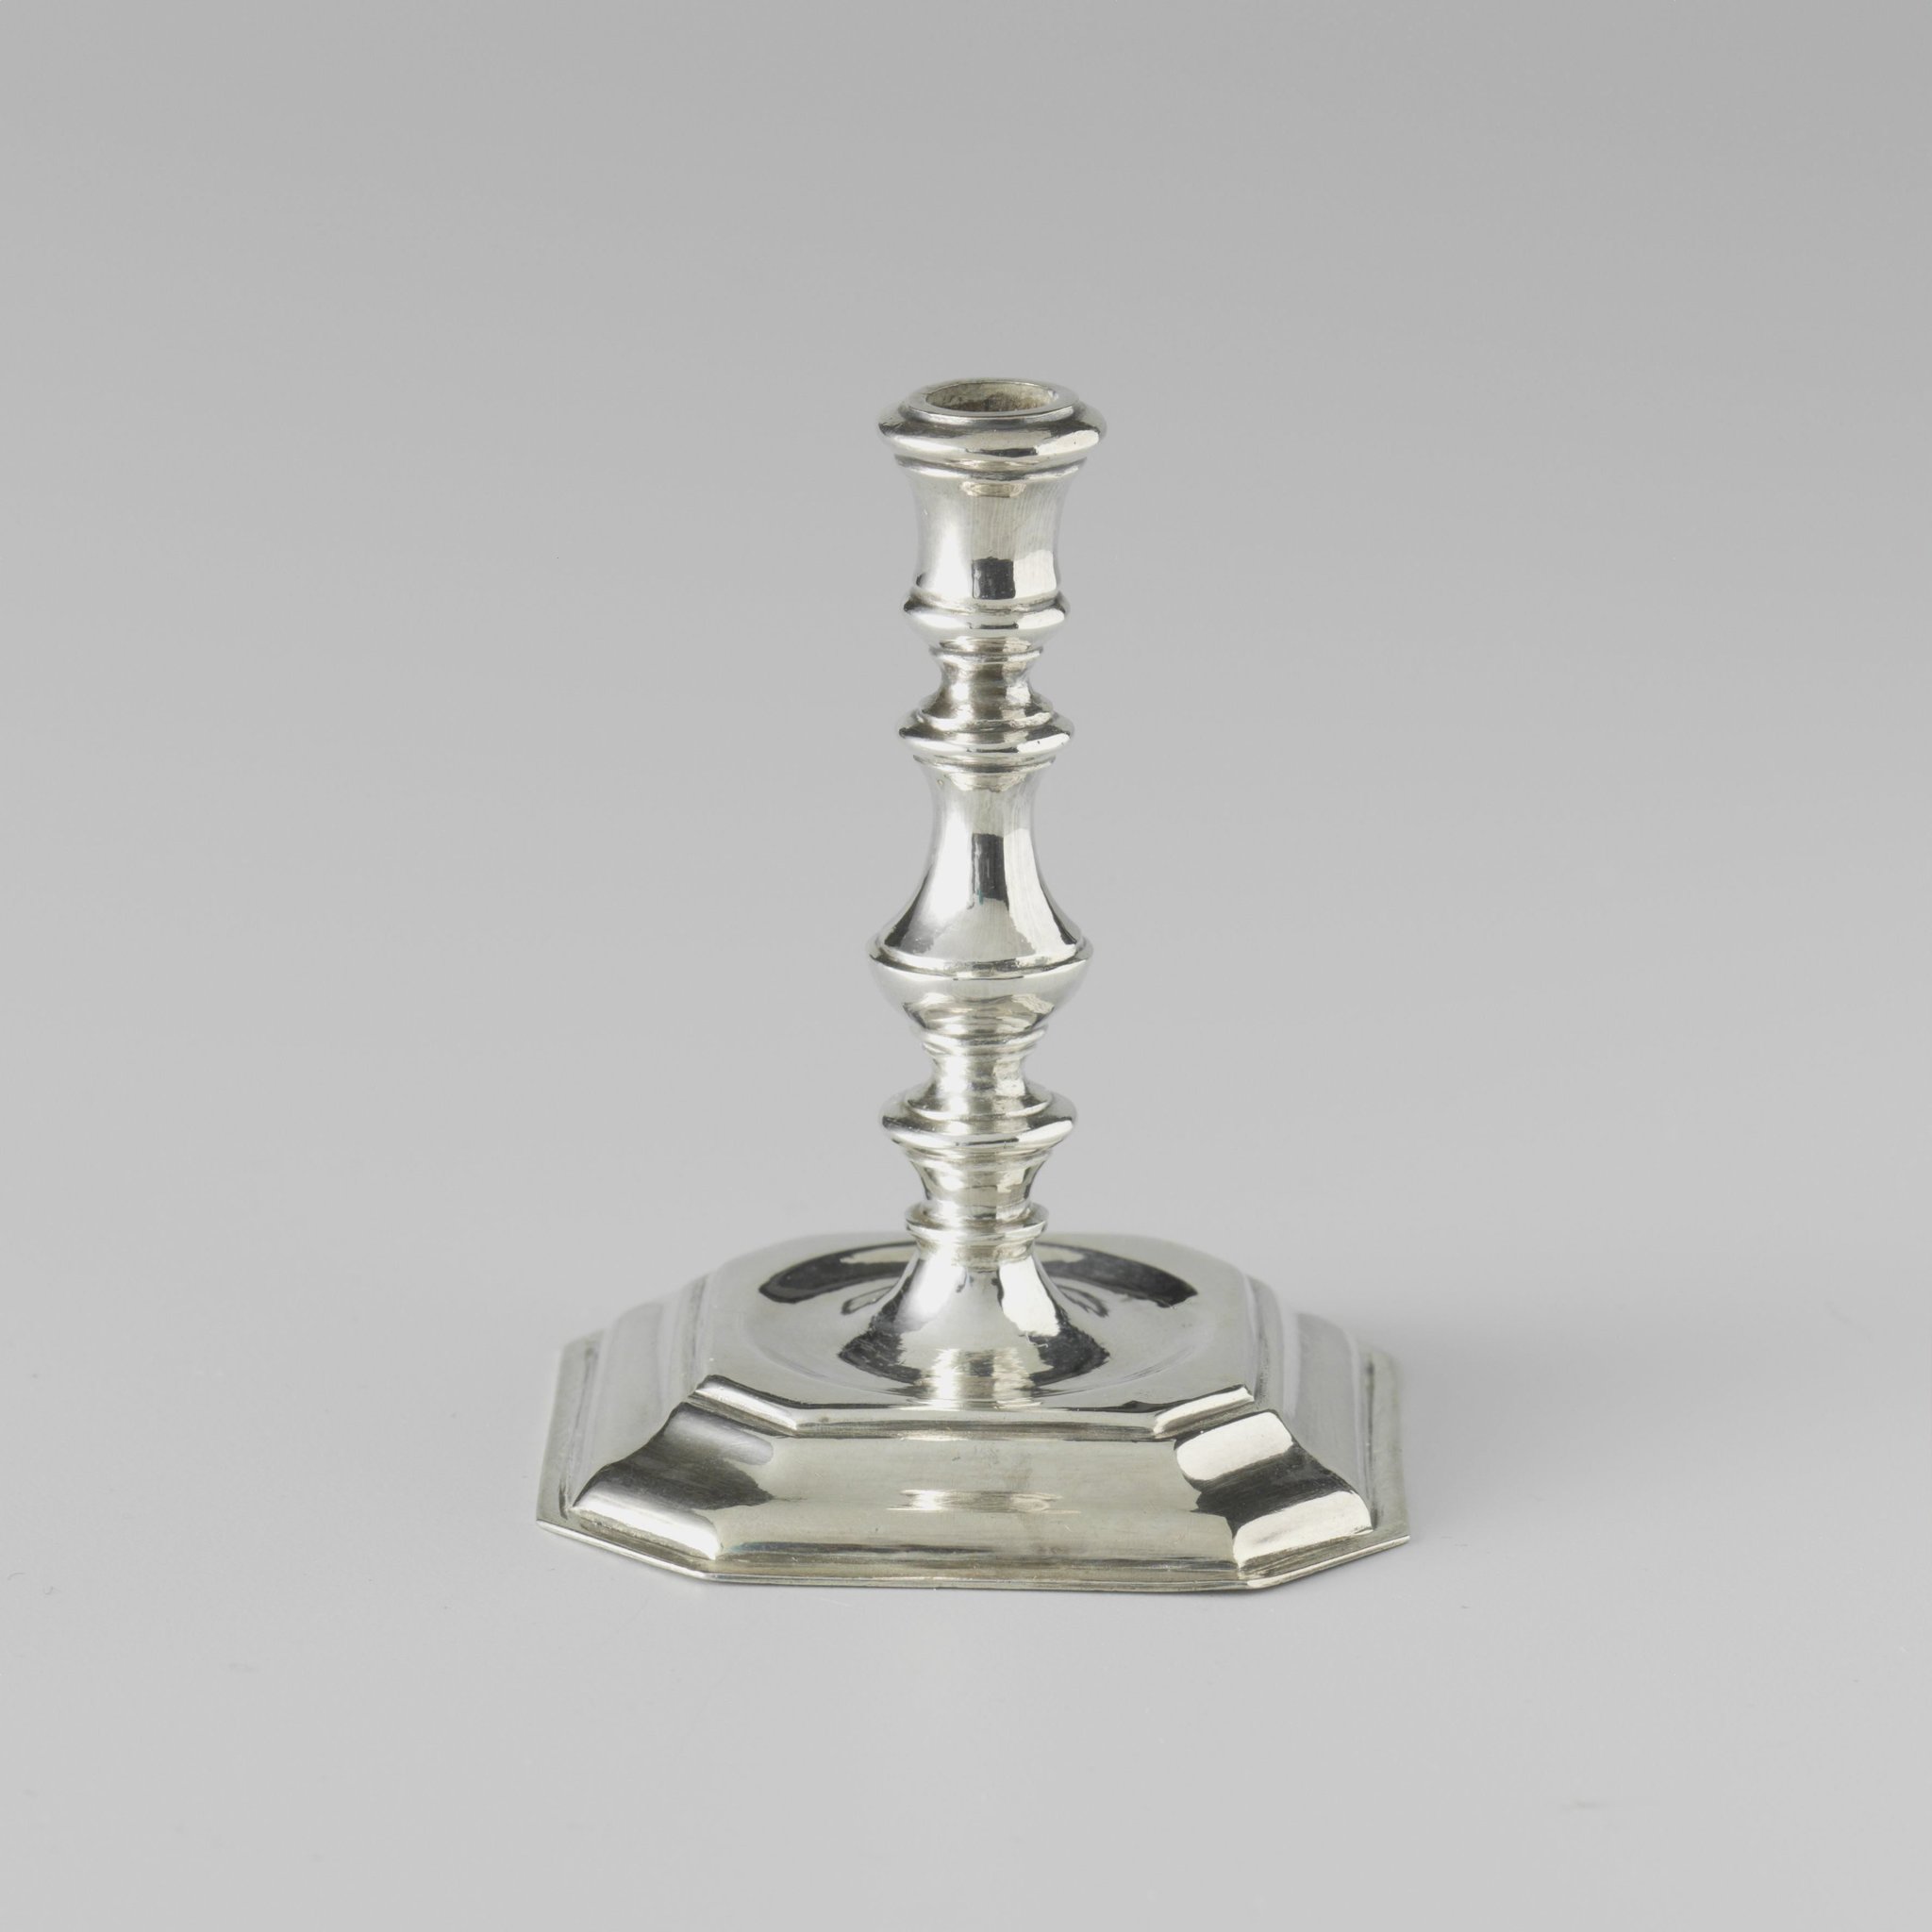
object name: candlestick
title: Kandelaar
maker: willem van strant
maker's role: silversmith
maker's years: 1682-1742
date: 1741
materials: silver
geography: amsterdam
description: Kandelaar op een vierkante, geprofileerde, gewelfde voet met afgeschuide hoeken. De stam is geprofileerd en balustervormig. De kandelaar is gemerkt: stk.= Amsterdam, jrl.= G (1741), mt.= Willem van Strant en een bijltje.